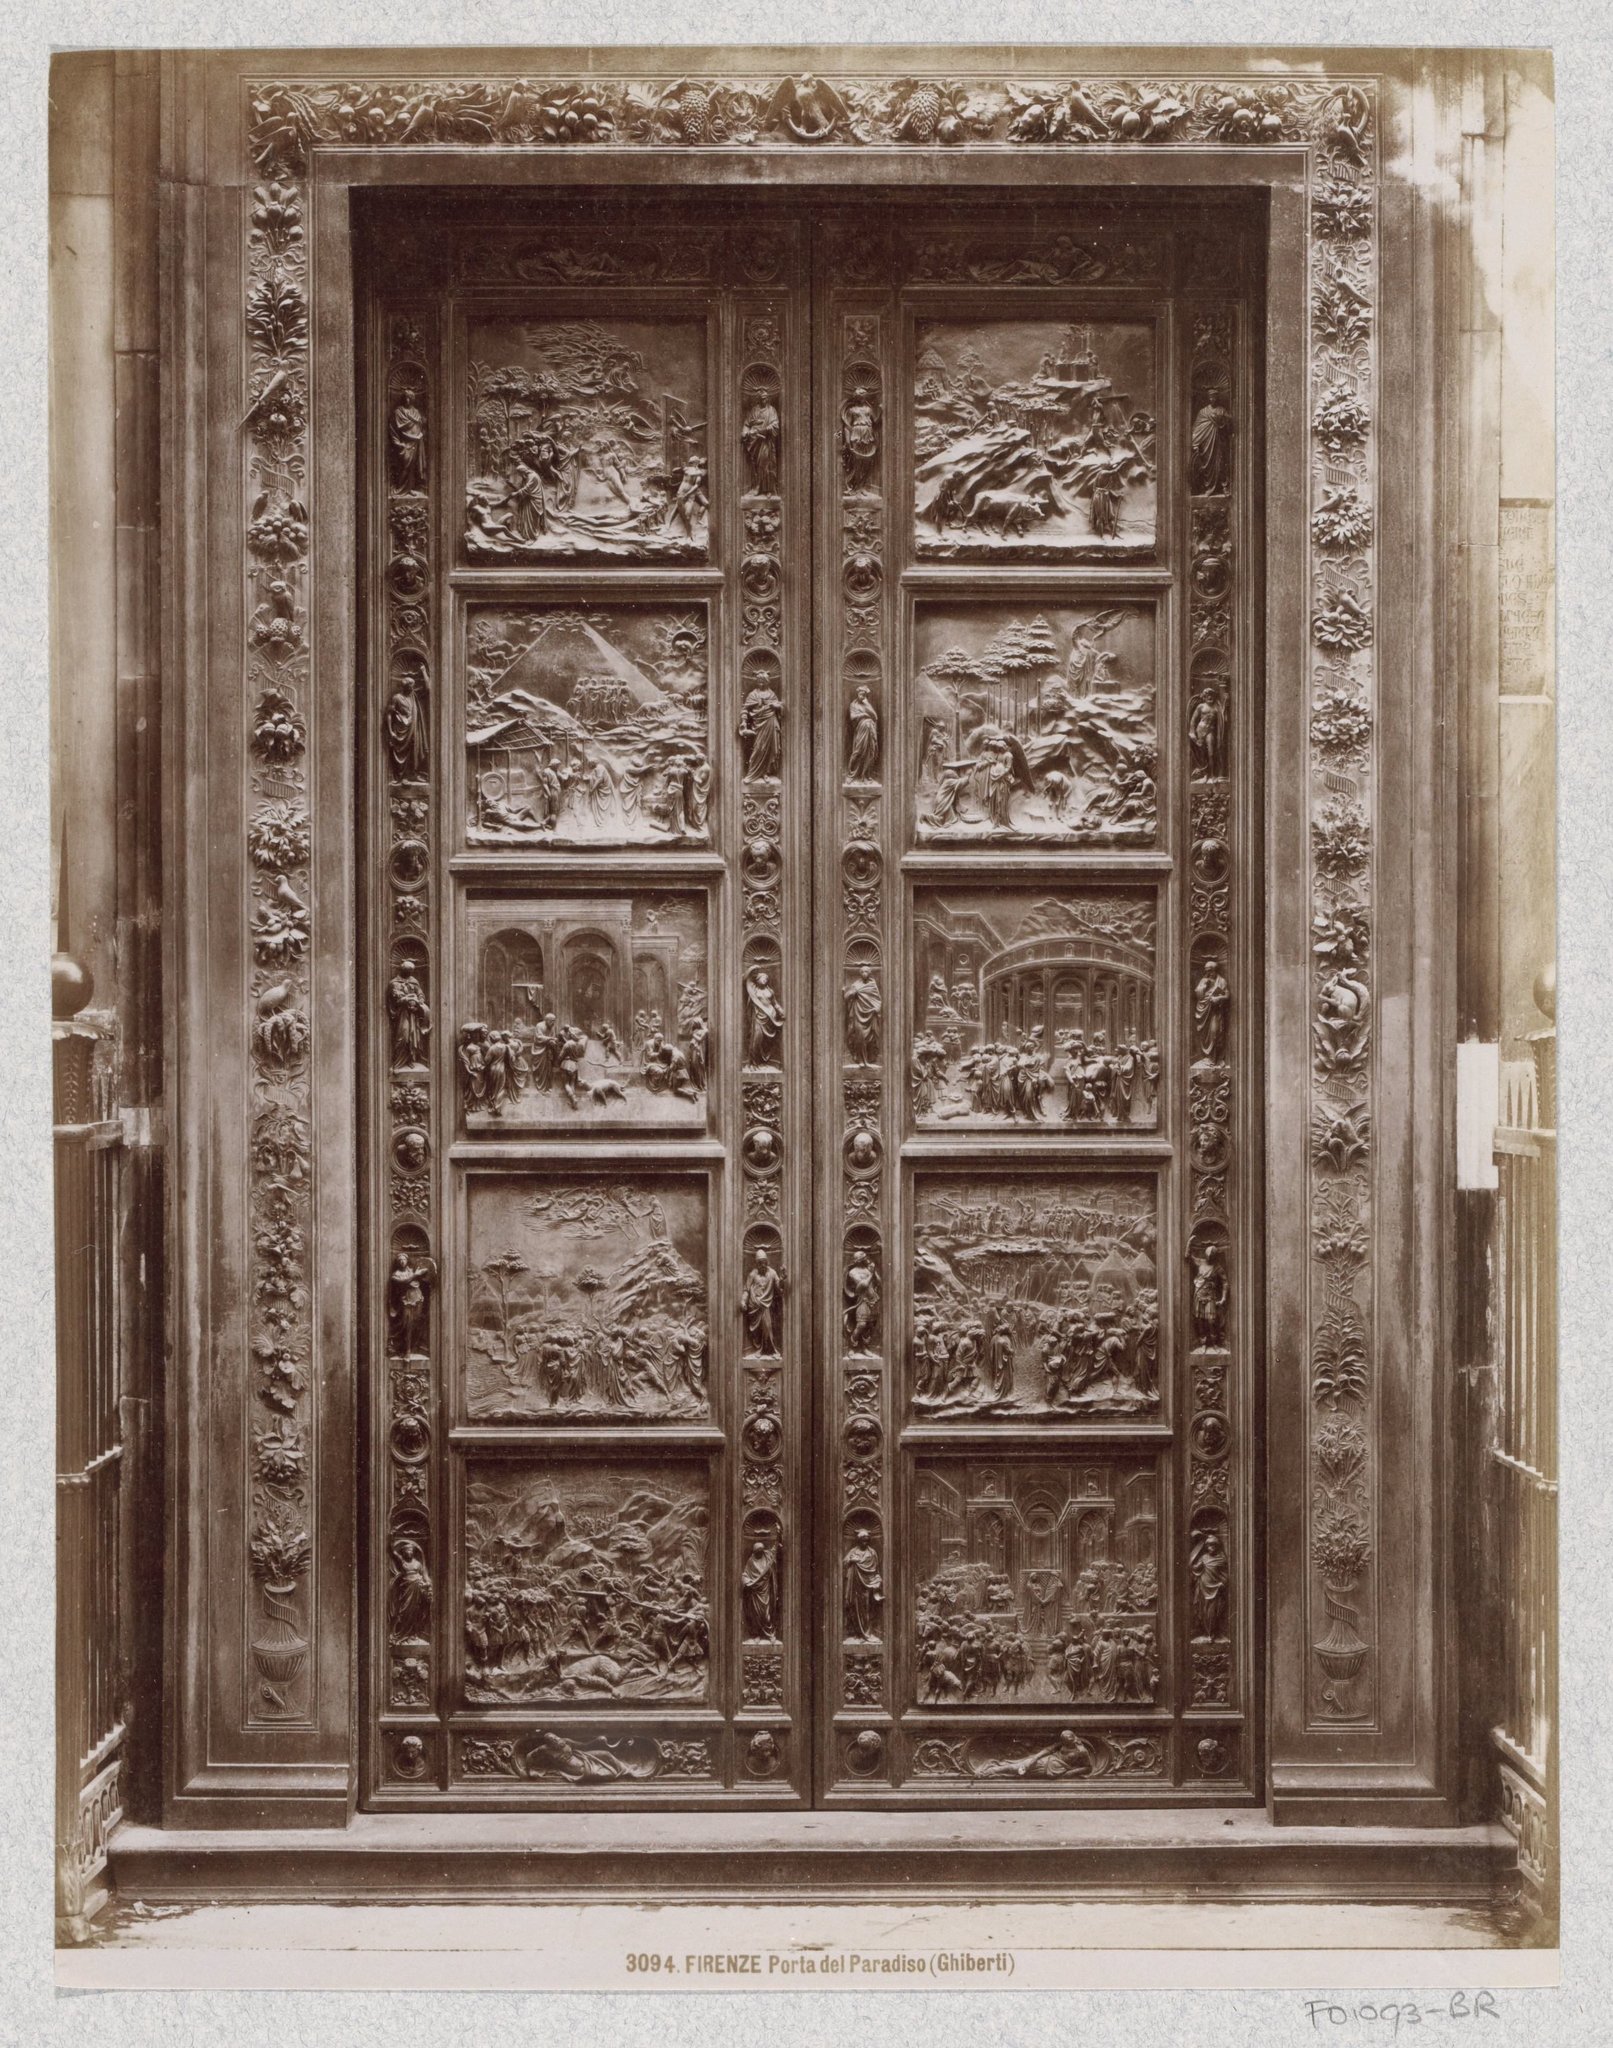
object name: photograph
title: Porta del Paradiso (Paradijsdeuren) van het Baptisterium van de Kathedraal van Florence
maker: Anonymous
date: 1870-1890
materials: paper, photographic support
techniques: albumen print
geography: florence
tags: gate, entrance, sculpture (+ relief ~ sculpture)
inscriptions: negative number: ‘3094’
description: Onderdeel van Reisalbum met foto's van bezienswaardigheden in Genua, Florence en Venetië.